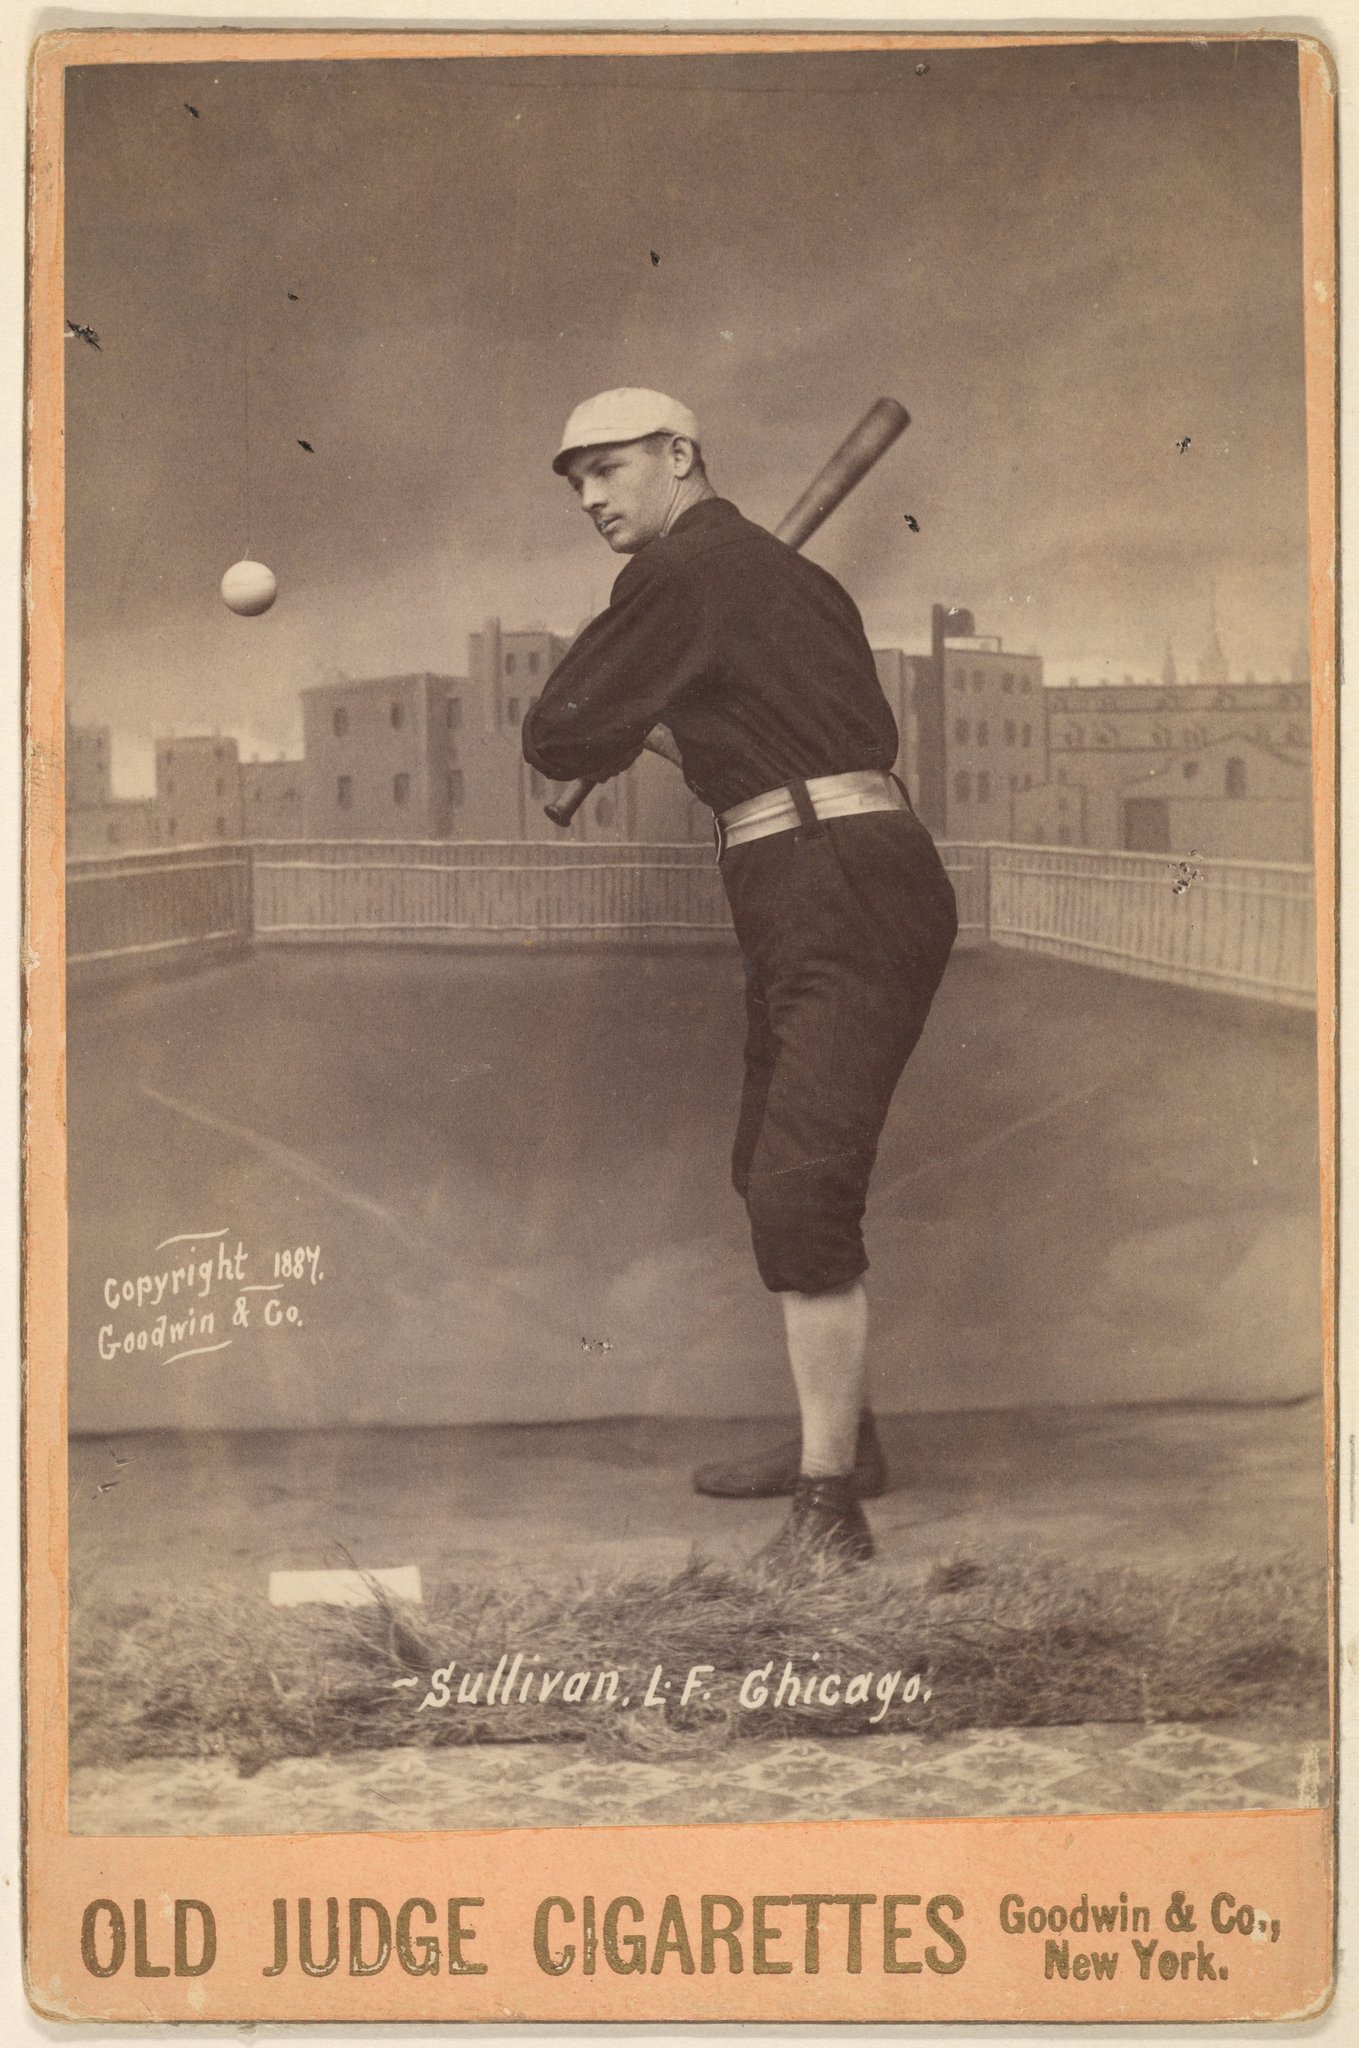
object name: baseball card, photograph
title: Sullivan, Left Field, Chicago, from the series Old Judge Cigarettes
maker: goodwin & company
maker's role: publisher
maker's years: 1850-1950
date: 1887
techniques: albumen silver print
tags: men,portraits,baseball,athletes